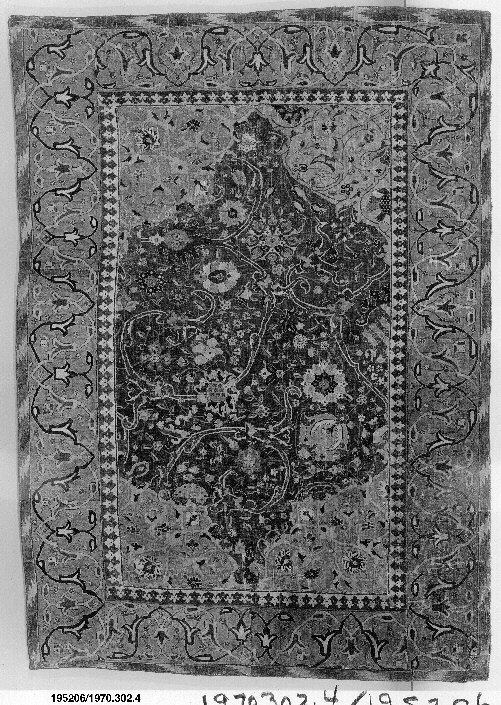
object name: carpet fragment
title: Joined Carpet Fragments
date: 1601-1700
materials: cotton, wool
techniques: asymmetrically knotted pile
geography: iran